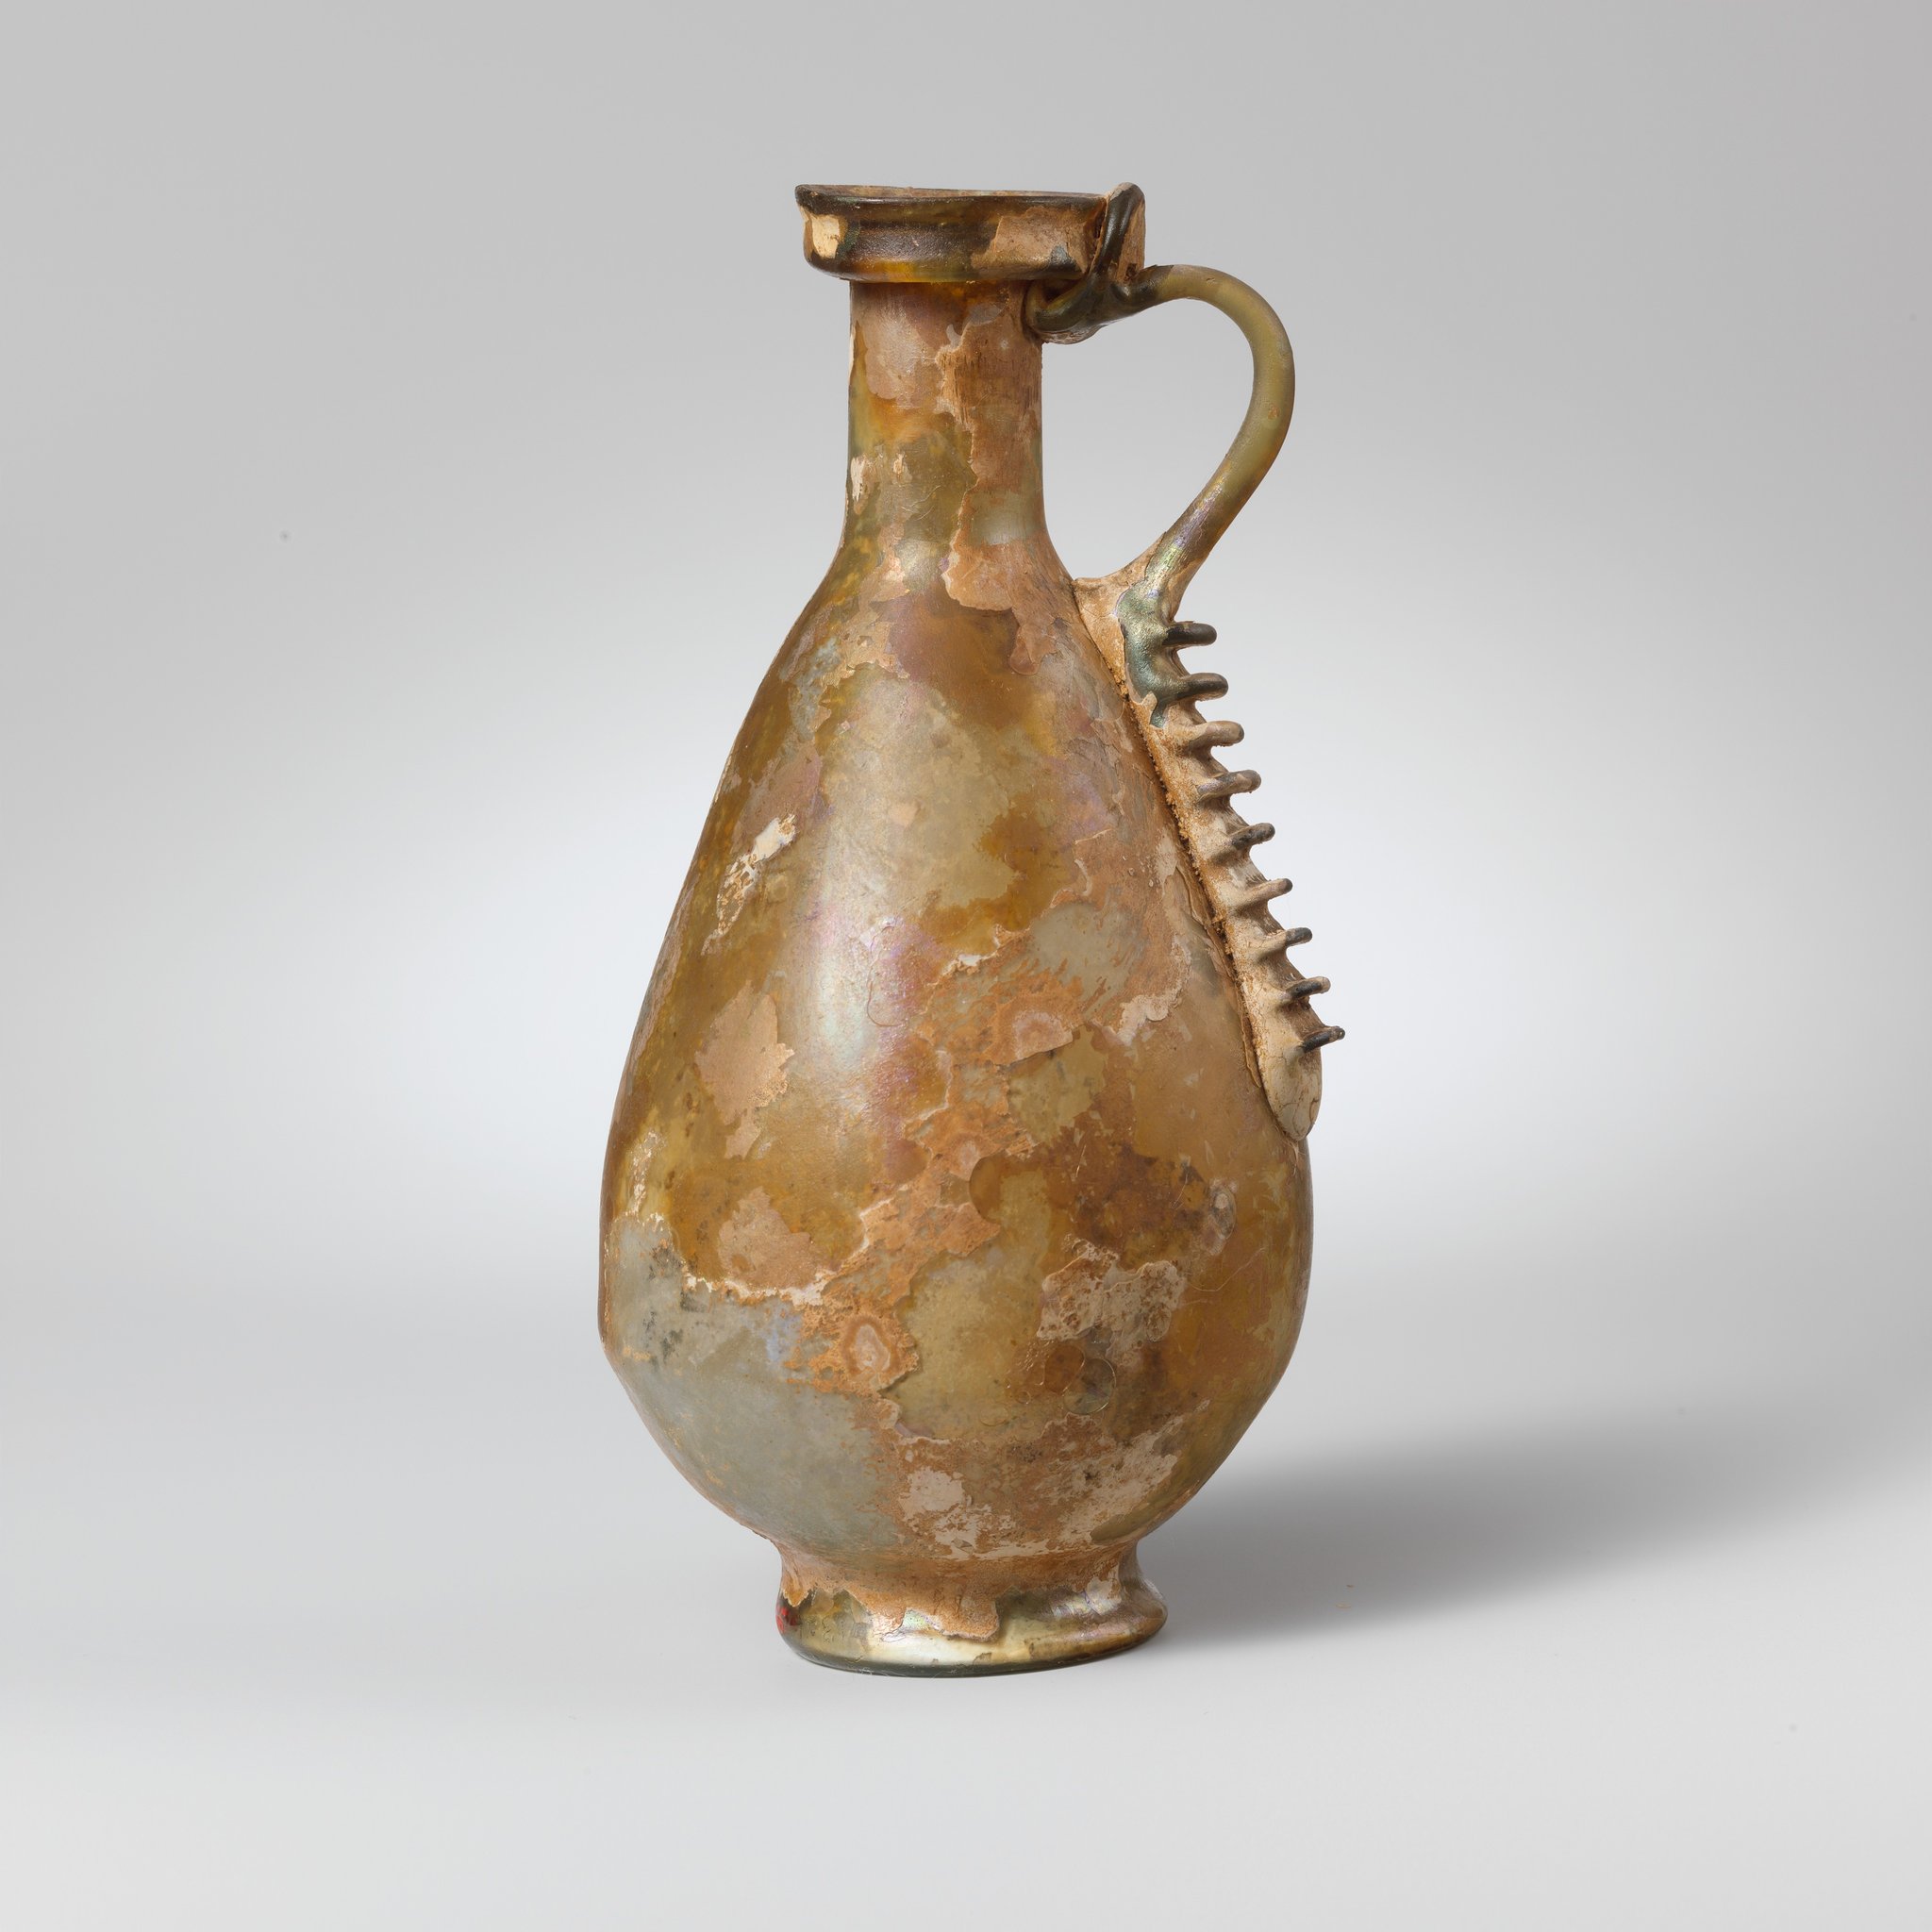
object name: jug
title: Glass jug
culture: roman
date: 34-66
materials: glass